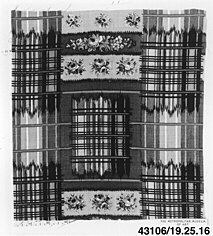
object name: sample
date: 1830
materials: wool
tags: flowers